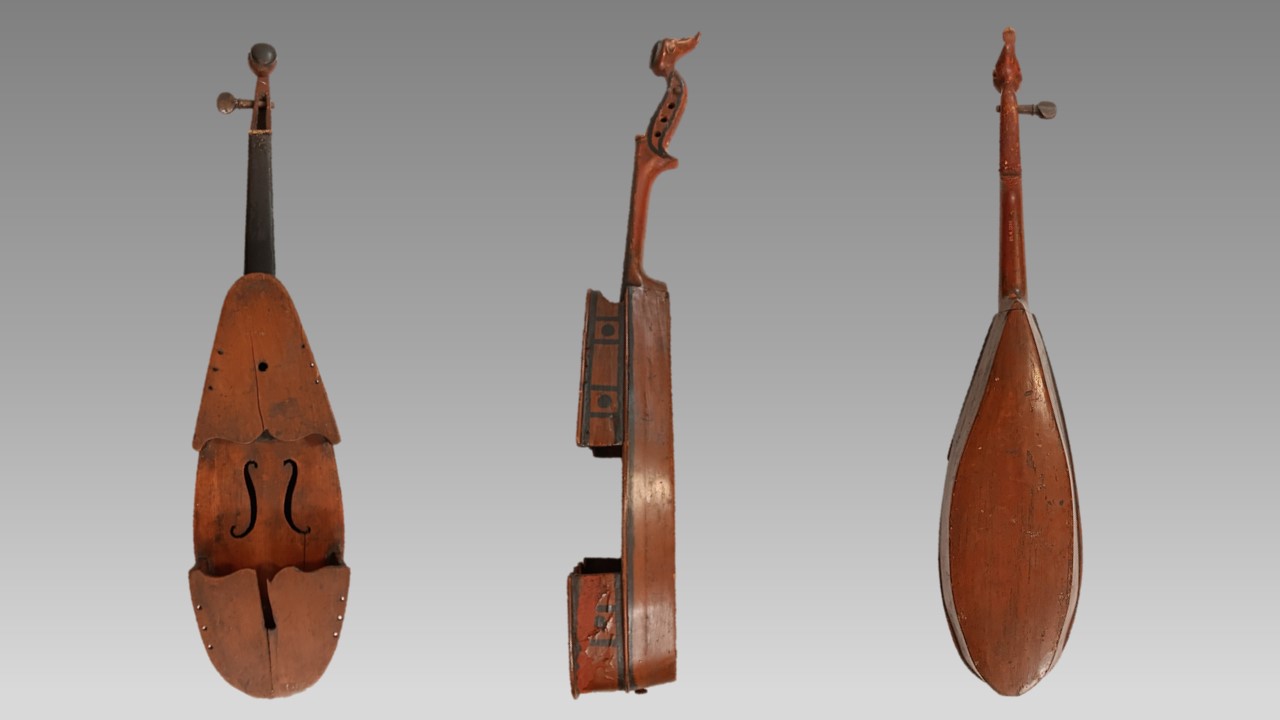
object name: stringed instrument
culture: melanesian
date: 1867-1900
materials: wood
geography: new guinea